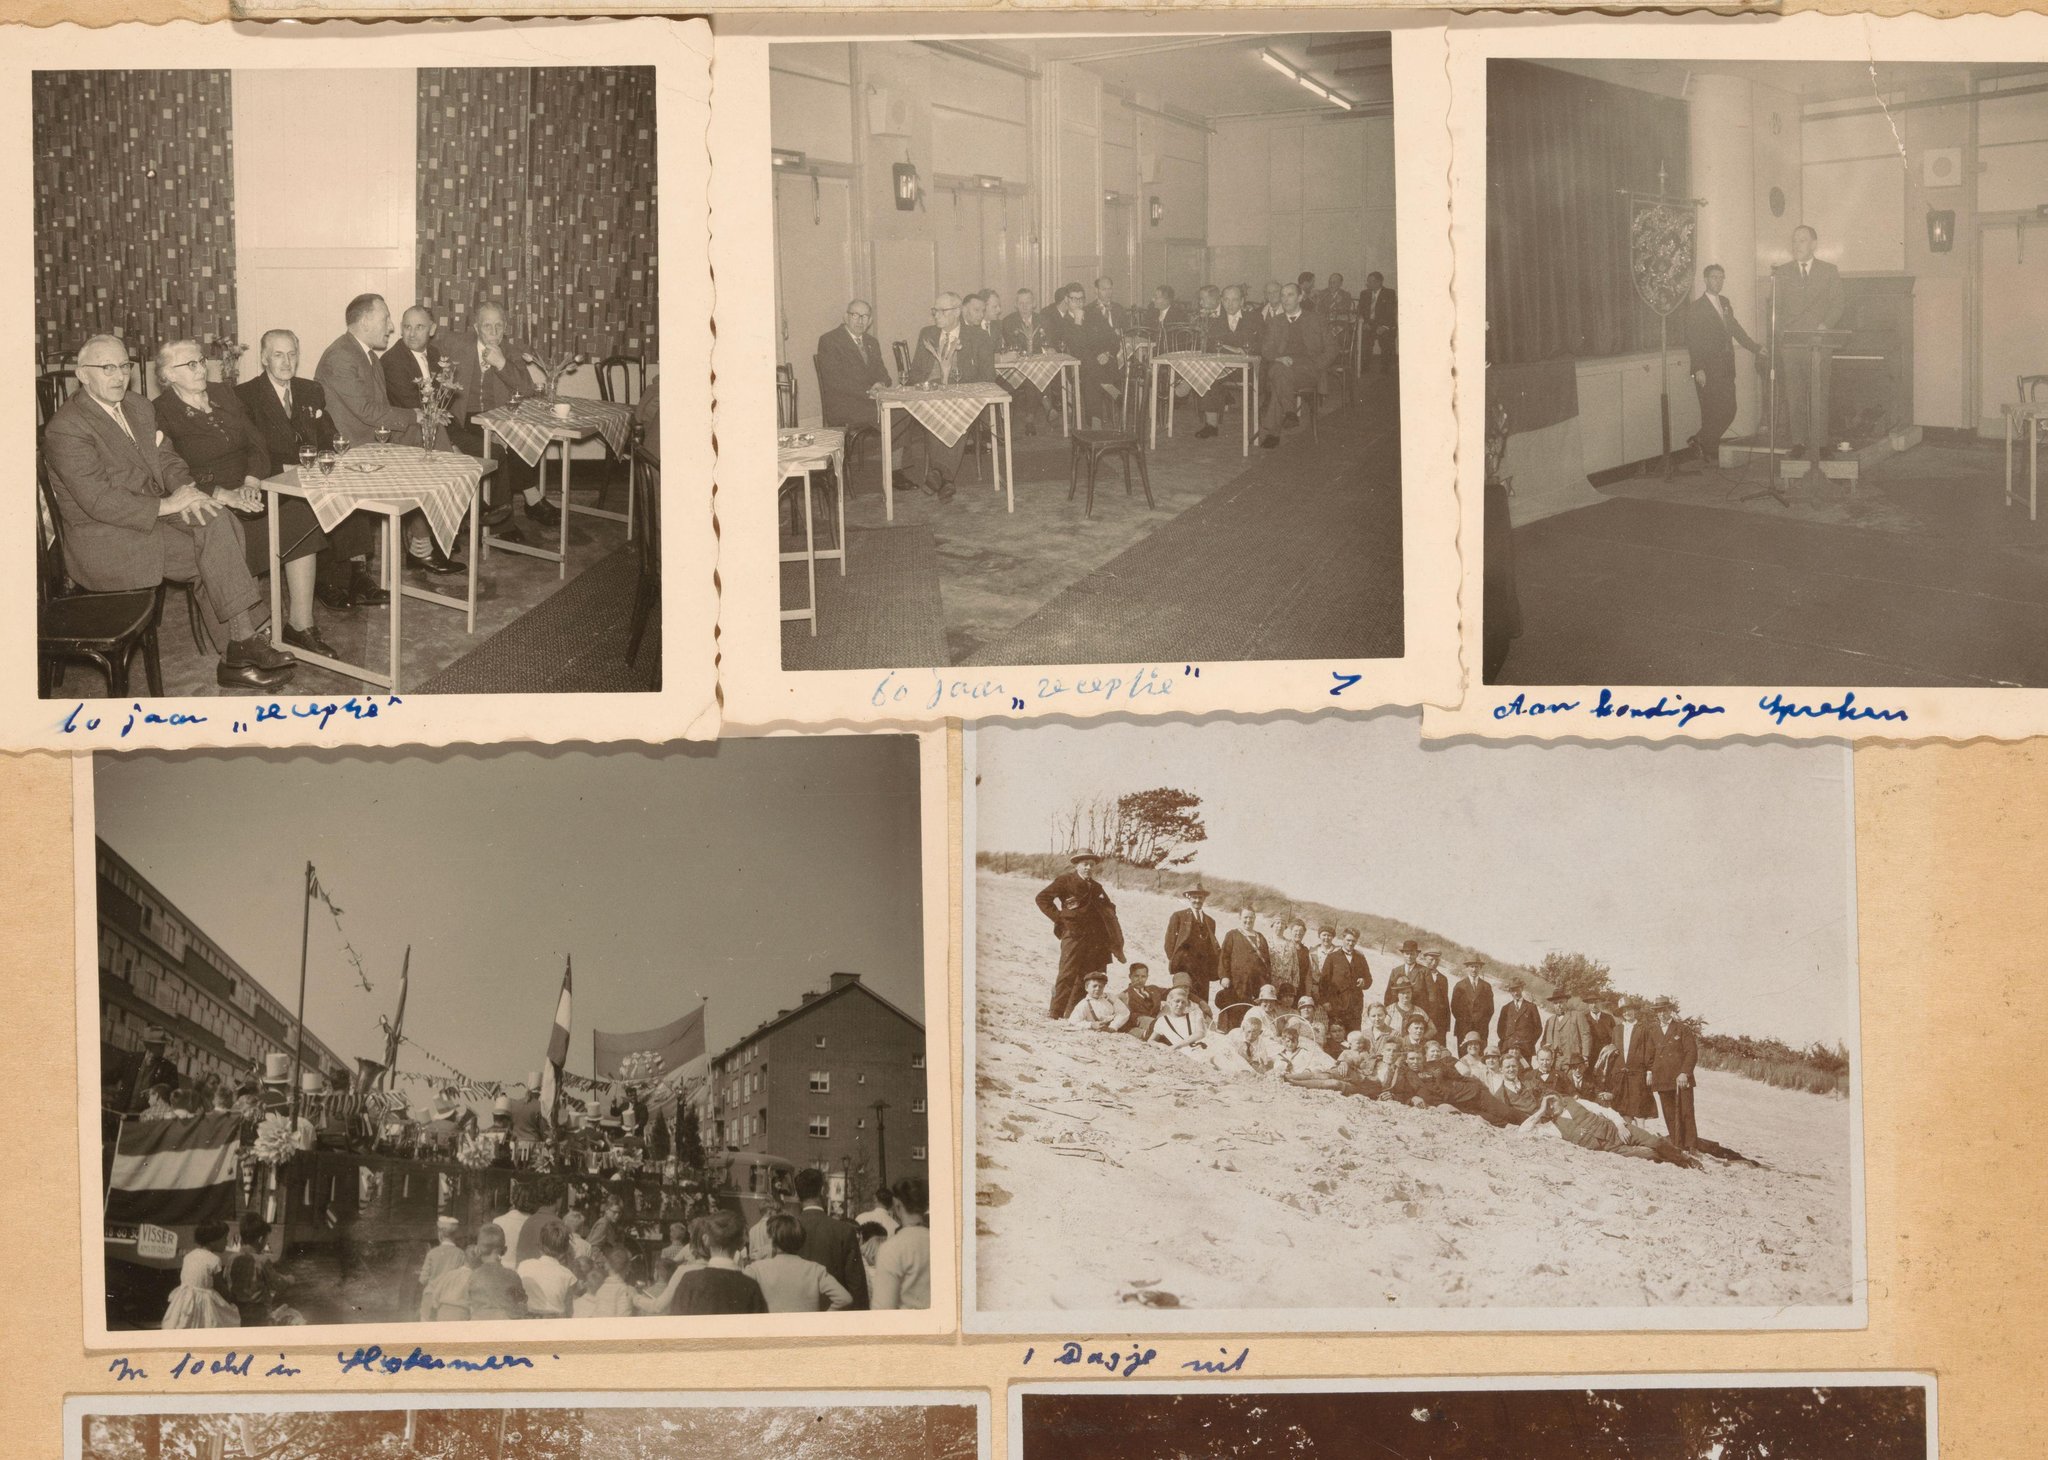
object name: photograph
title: 1 dagje uit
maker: Anonymous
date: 1930-1950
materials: cardboard, photographic support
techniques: gelatin silver print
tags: beach (as place of recreation)